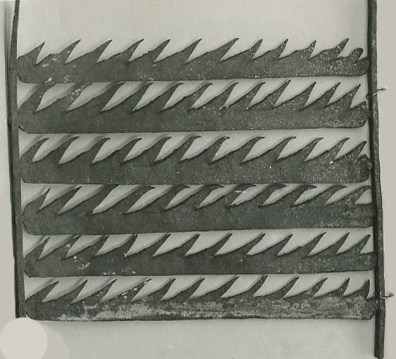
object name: grill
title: Grille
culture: european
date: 1401-1600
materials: iron